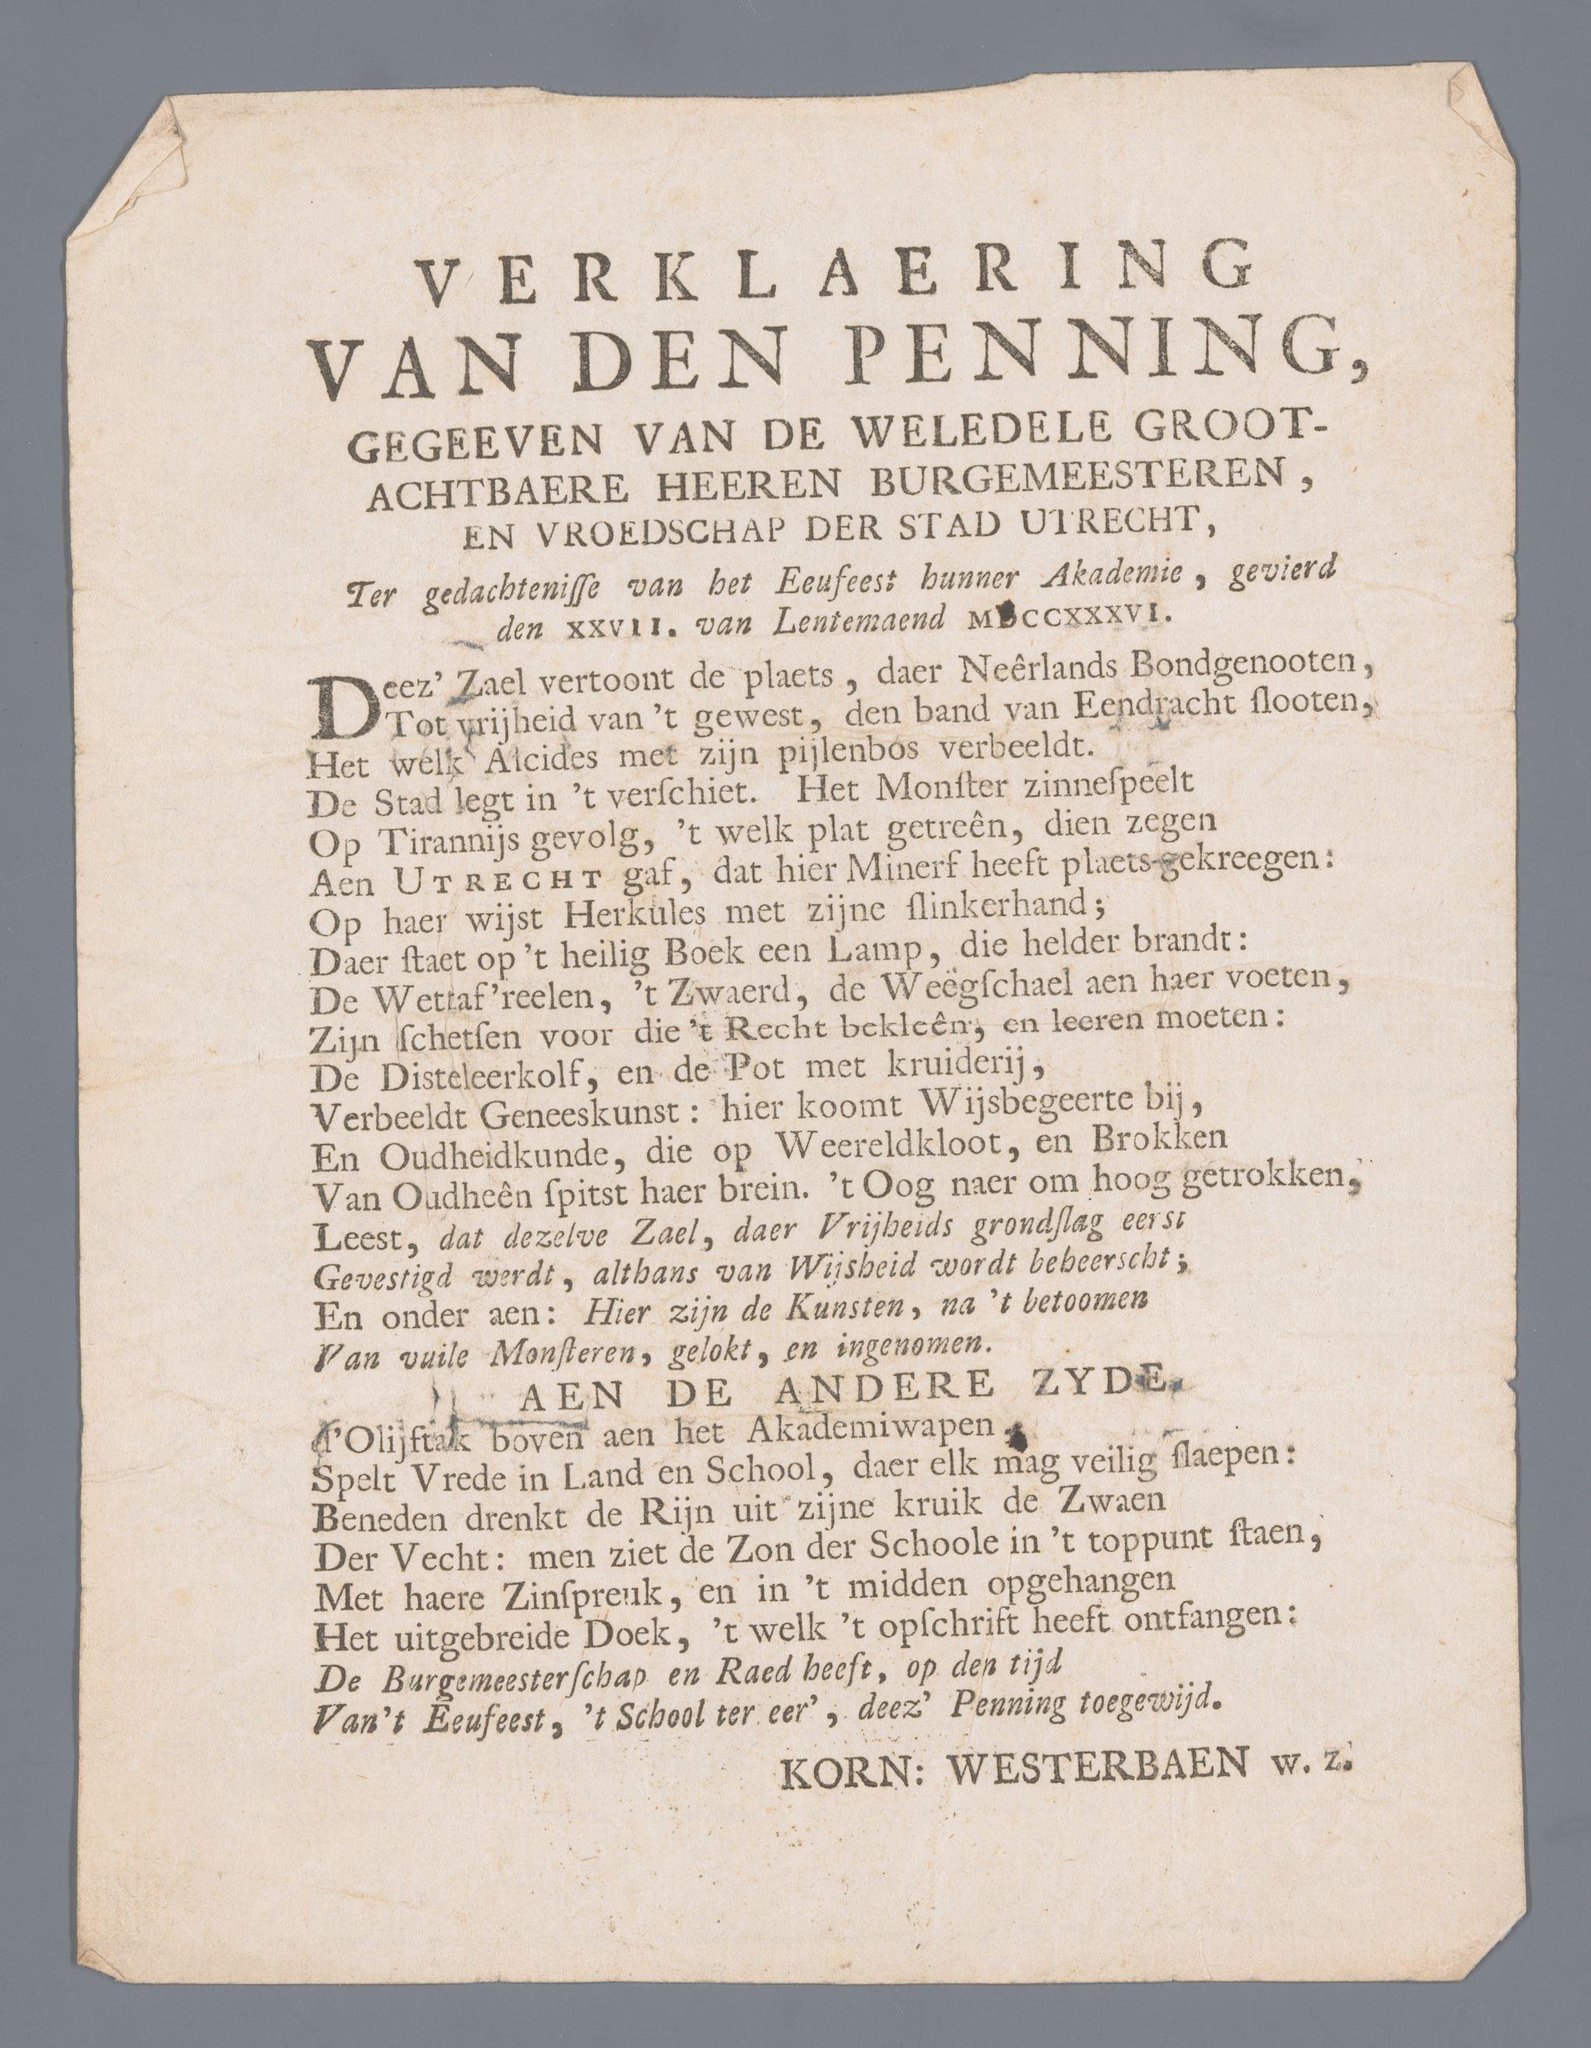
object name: penningverklaring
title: Verklaring van de penning door Johannes Drappentier sr. geslagen op het eeuwfeest van de Hogeschool te Utrecht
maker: Anonymous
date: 1736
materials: paper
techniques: printing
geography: netherlands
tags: utrecht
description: Eenzijdig, rechthoekig papier met opschrift, gedrukt in zwarte inkt. Keerzijde: letter L in bruine inkt geschreven.